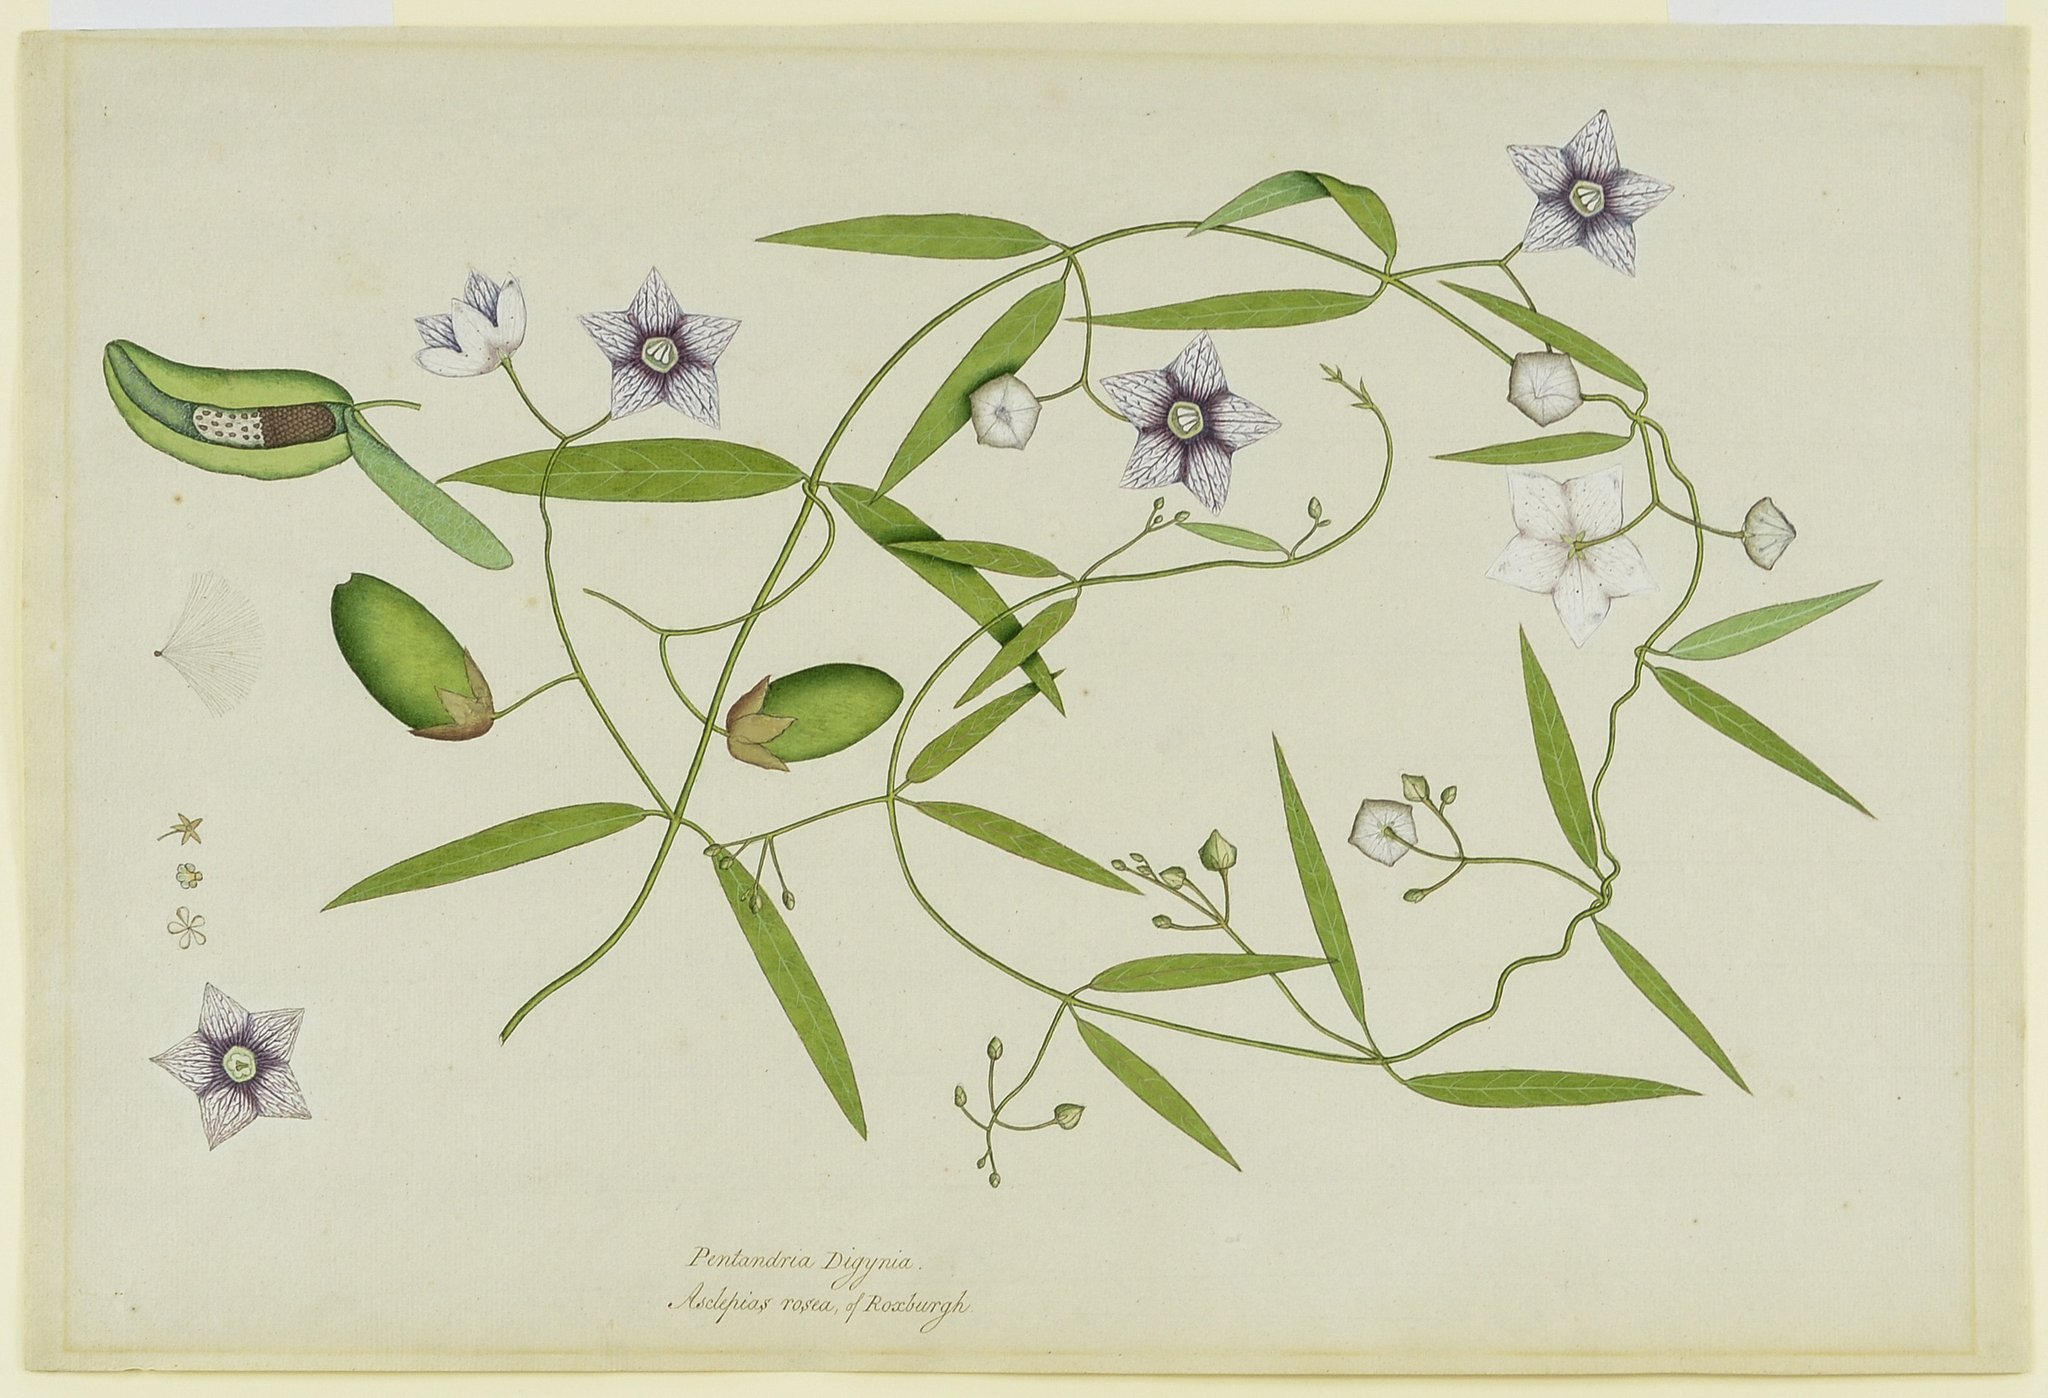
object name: illustrated single work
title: Rosy Milkweed Vine/Asclepias Rosea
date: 1767-1800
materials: paper, watercolor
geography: india